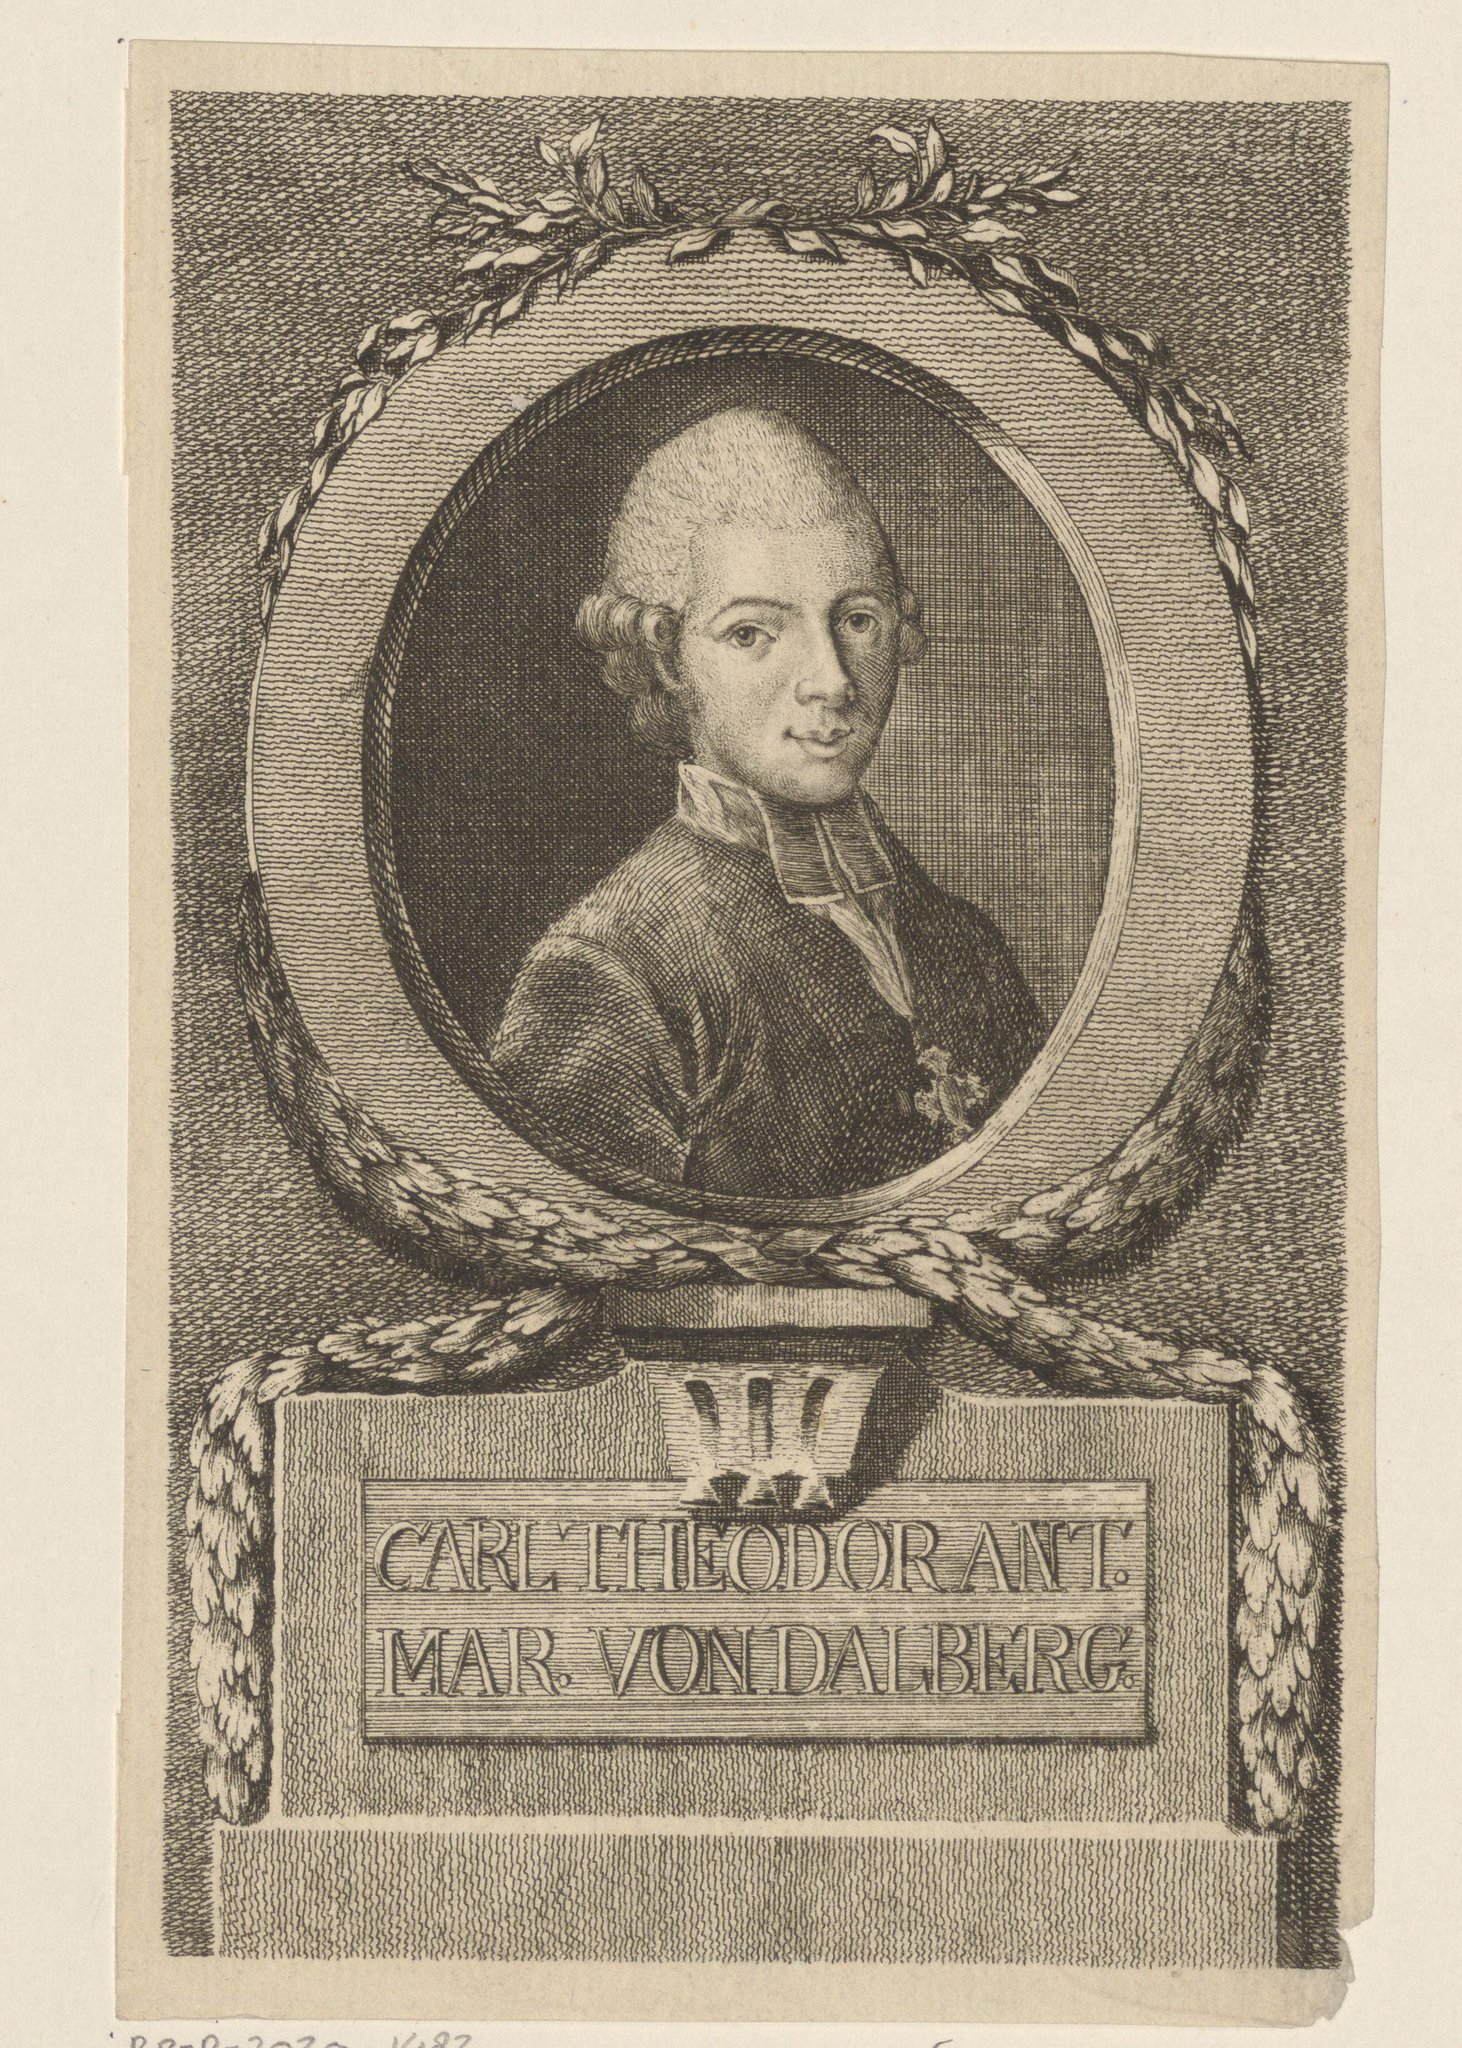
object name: print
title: Portret van Carl Theodor Anton Maria von Dalberg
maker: Anonymous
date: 1761-1817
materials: paper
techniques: engraving, etching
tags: karl theodor von dalberg, archbishop, bishop, etc. (roman catholic), historical persons